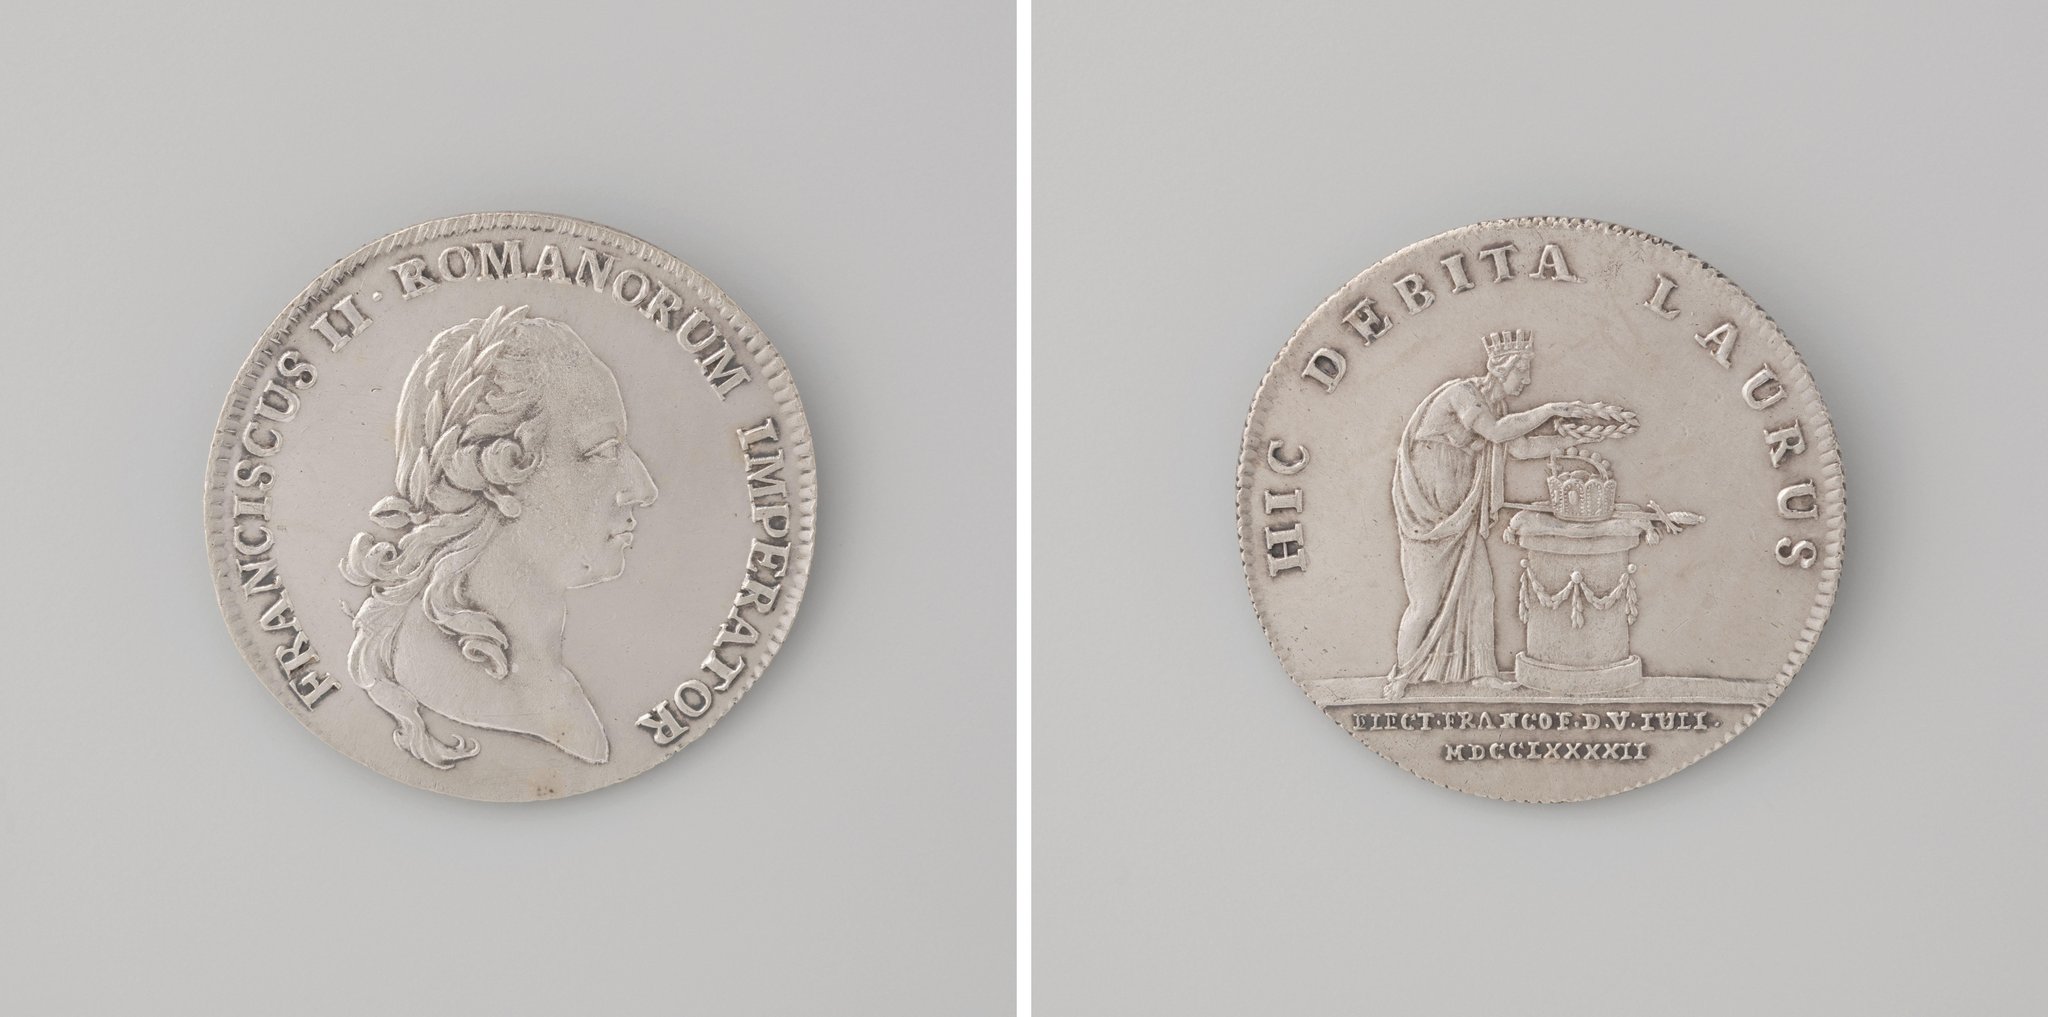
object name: history medal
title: Frans II tot Duits keizer gekozen te Frankfurt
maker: Anonymous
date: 1792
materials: silver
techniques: striking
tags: vienna, frans ii (rooms-duits keizer)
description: Zilveren penning. Voorzijde: borststuk man met lauwerkrans binnen omschrift. Keerzijde: gekroonde vrouw houdt lauwerkrans boven op altaar liggende keizerskroon en zwaard binnen omschrift; afsnede: opschrift